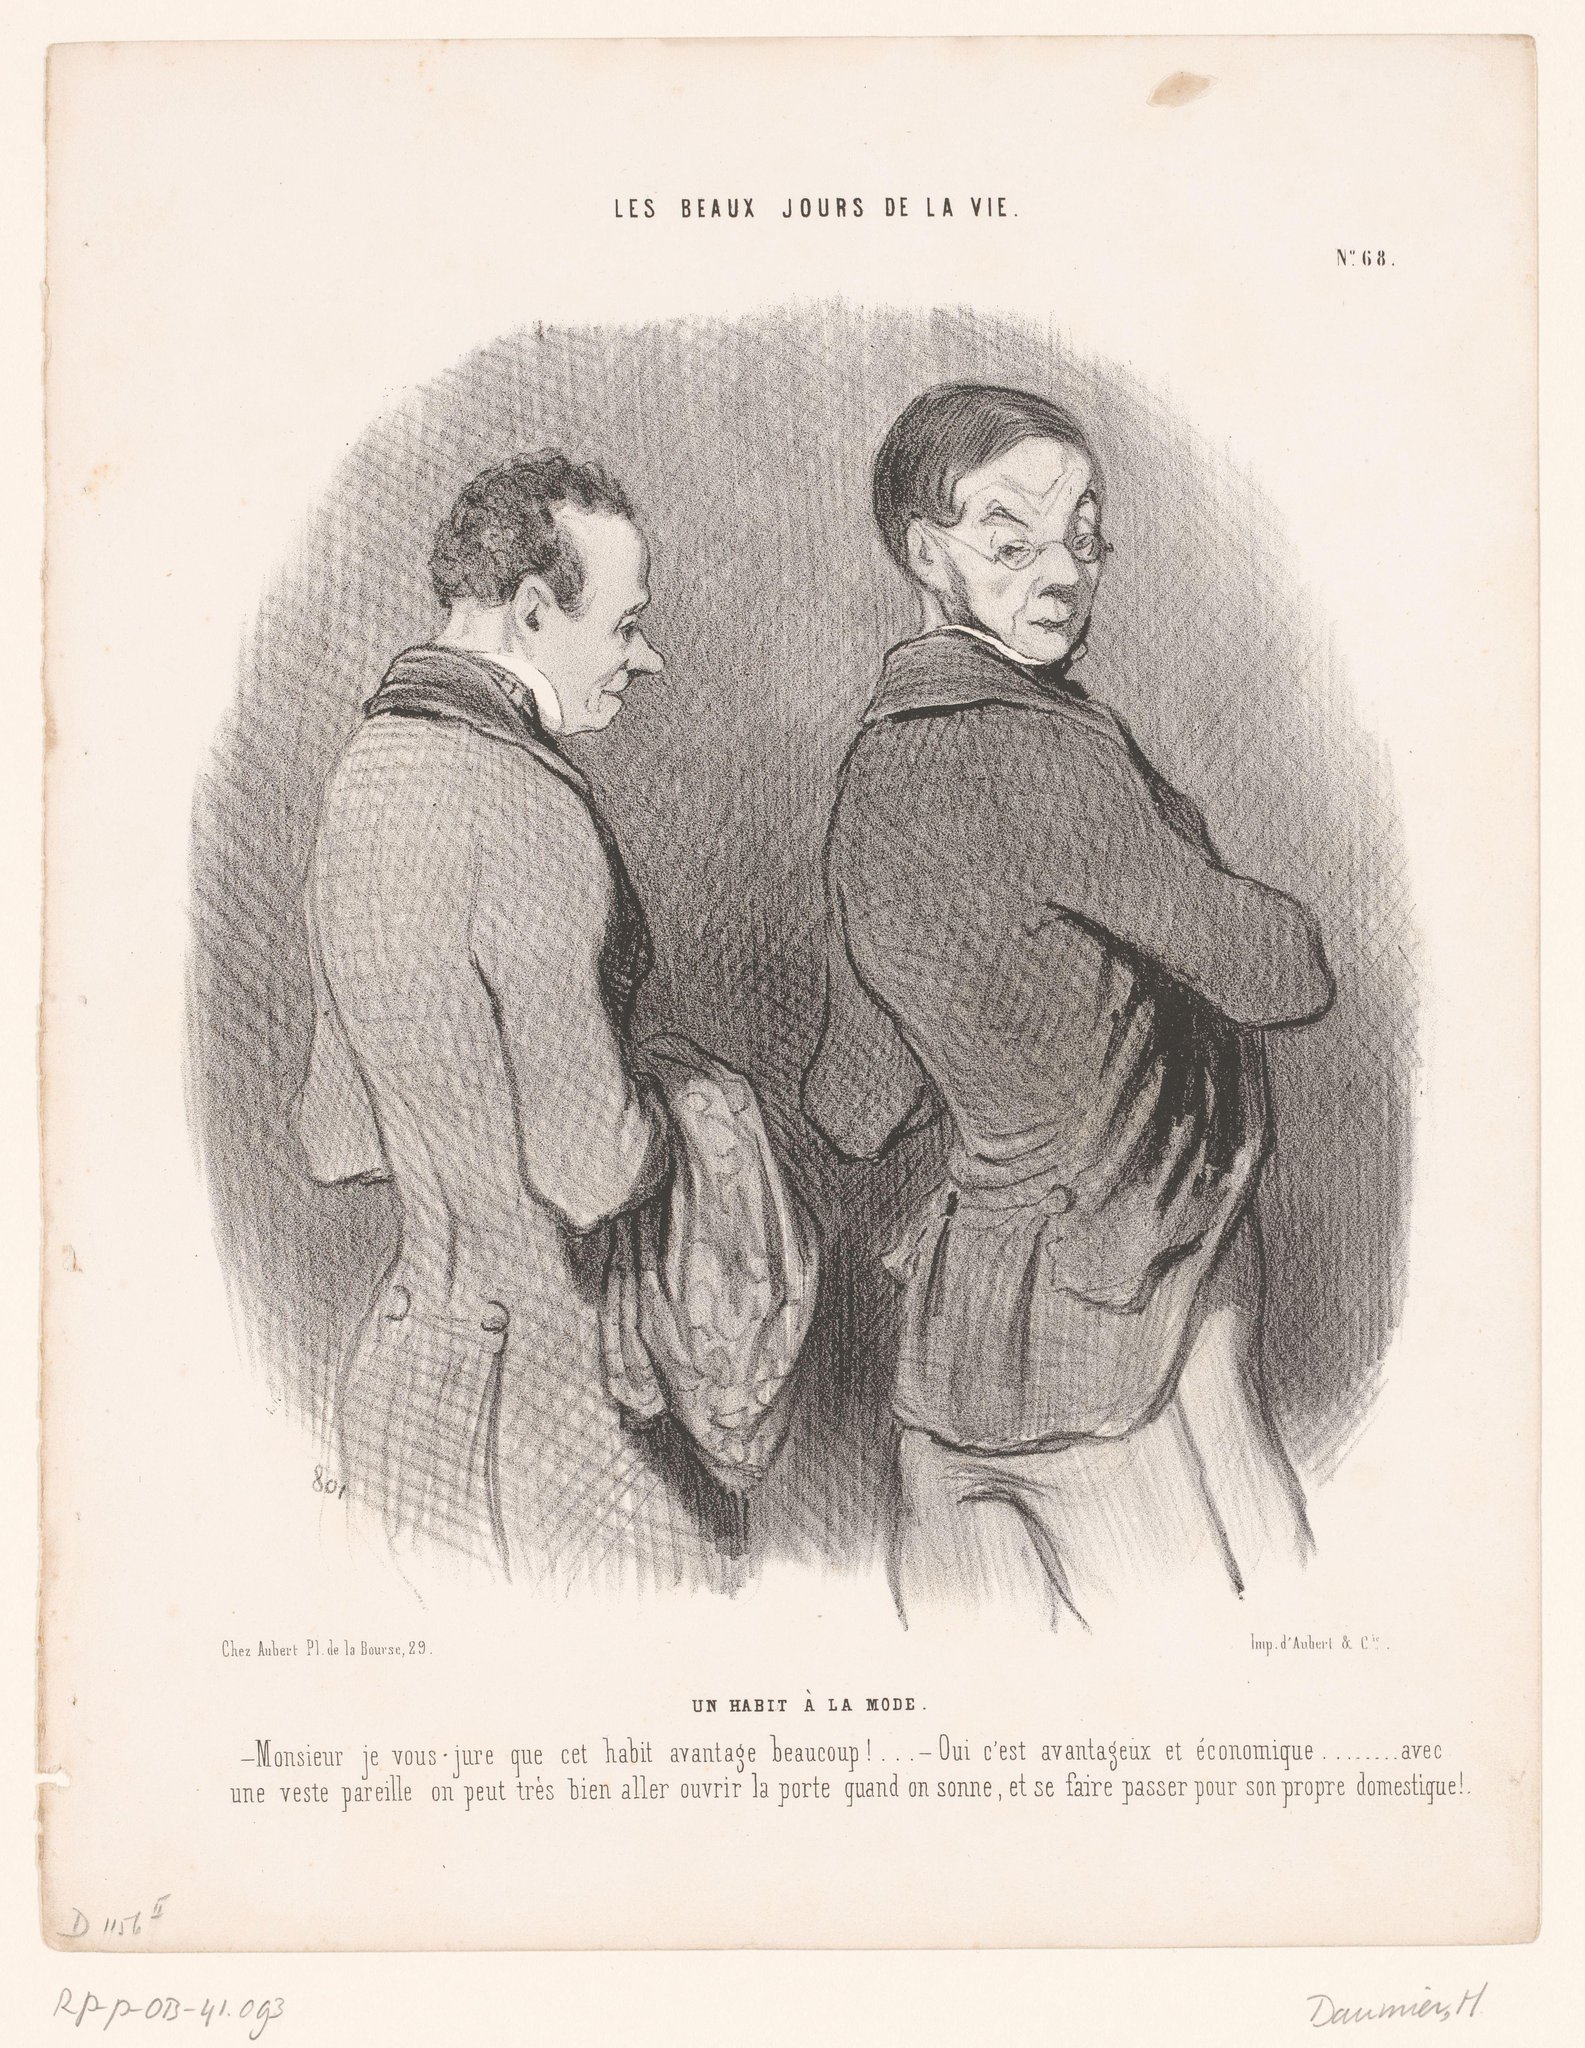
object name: cartoon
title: Un habit à la mode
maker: honoré daumier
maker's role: draughtsman, painter, print maker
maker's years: 1808-1879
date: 1845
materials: paper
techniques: lithograph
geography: paris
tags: caricatures (human types), clothing for the upper part of the body, tailor, dressmaker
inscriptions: collector's mark: Lugt 2228a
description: Prent gepubliceerd in: Le Charivari, Aubert: Parijs, 28-08-1845. Le Charivari was een humoristische krant met karikaturen en (politieke) cartoons.